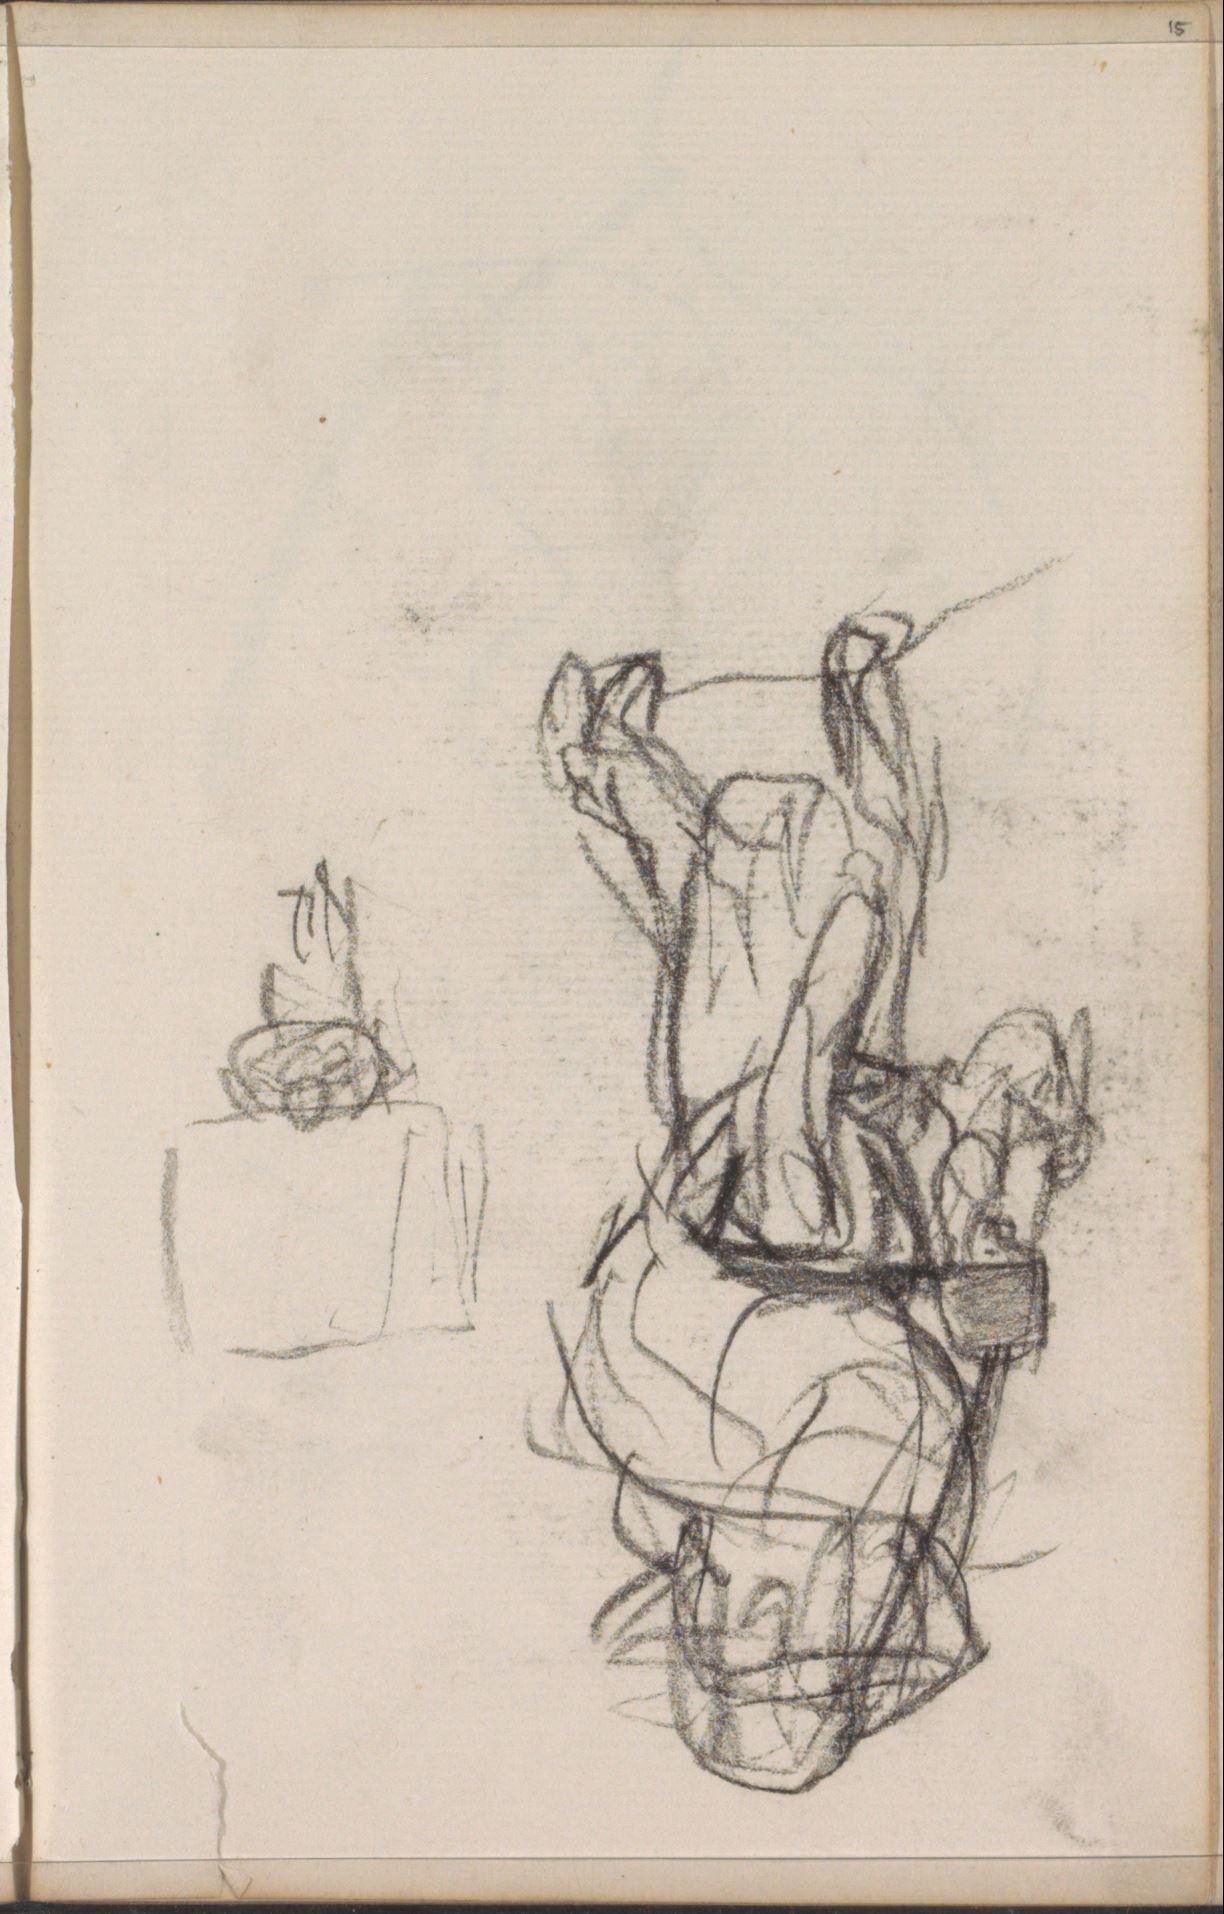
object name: sketchbook leaf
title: Lastdragers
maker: marius bauer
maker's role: draughtsman, print maker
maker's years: 1867-1932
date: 1899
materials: chalk, paper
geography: turkey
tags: asiatic races and peoples, carrying something, porter, bearer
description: Pagina 15 uit een schetsboek met 42 bladen.